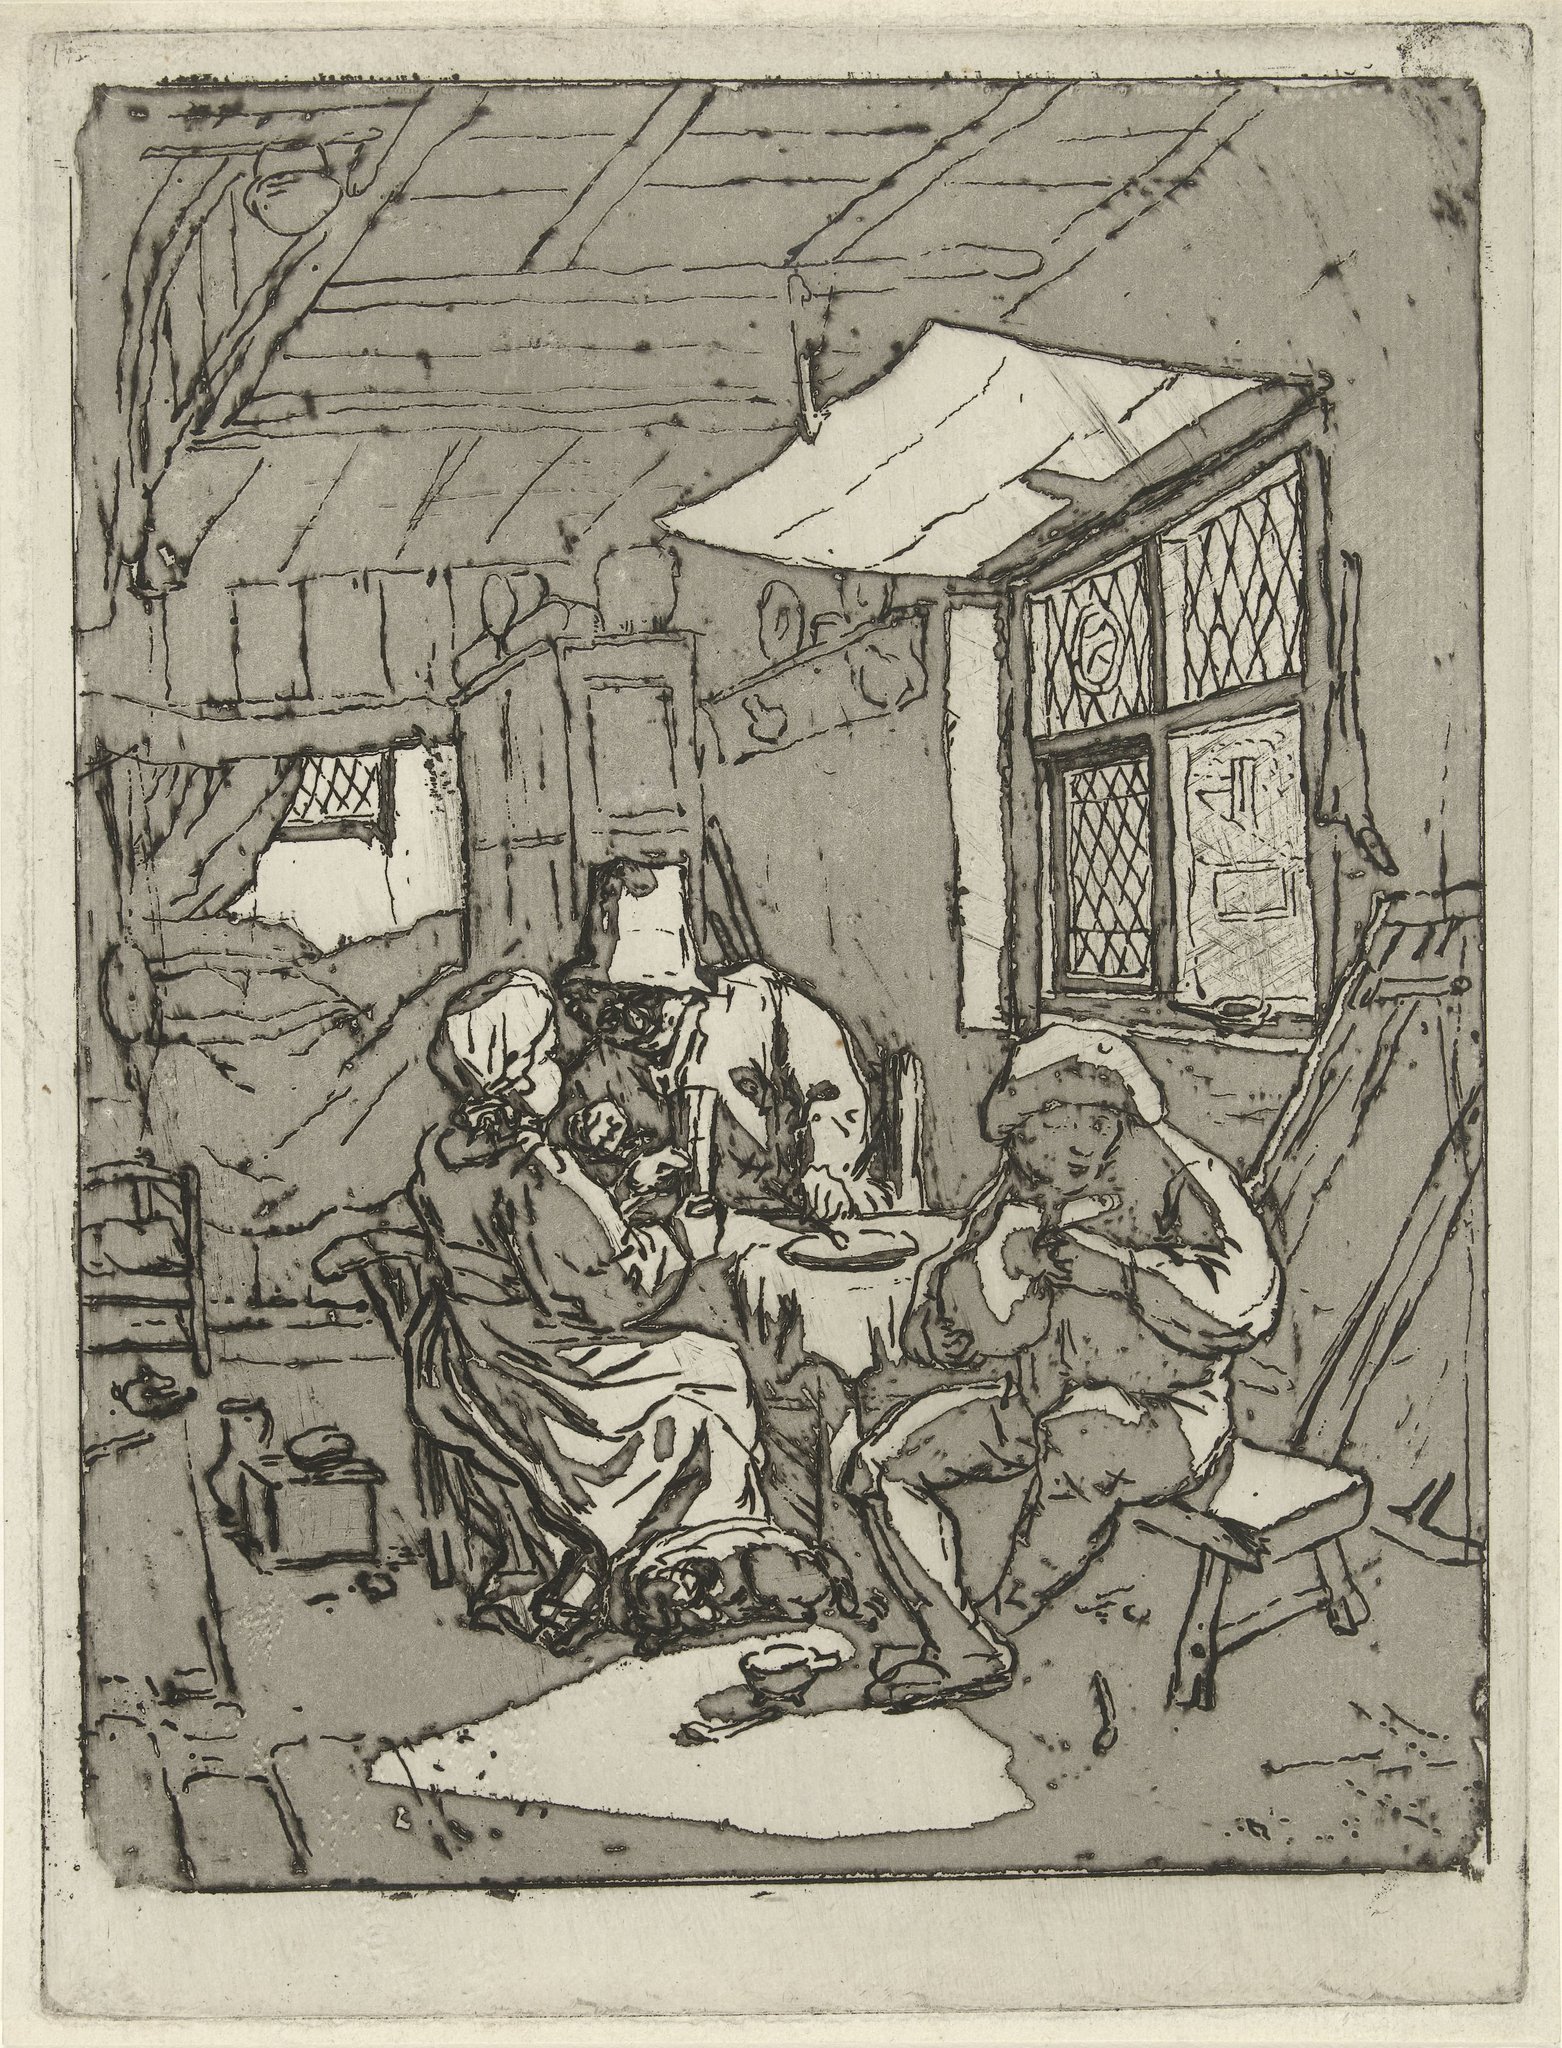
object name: print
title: Boereninterieur (tweede versie)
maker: jabes heenck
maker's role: draughtsman, print maker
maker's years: 1752-1782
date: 1767-1782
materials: paper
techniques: aquatint, drypoint, etching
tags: interior of the house, open window, drinking, dog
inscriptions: collector's mark: Lugt 2228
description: Drie figuren aan een tafel bij een open raam in een boereninterieur.